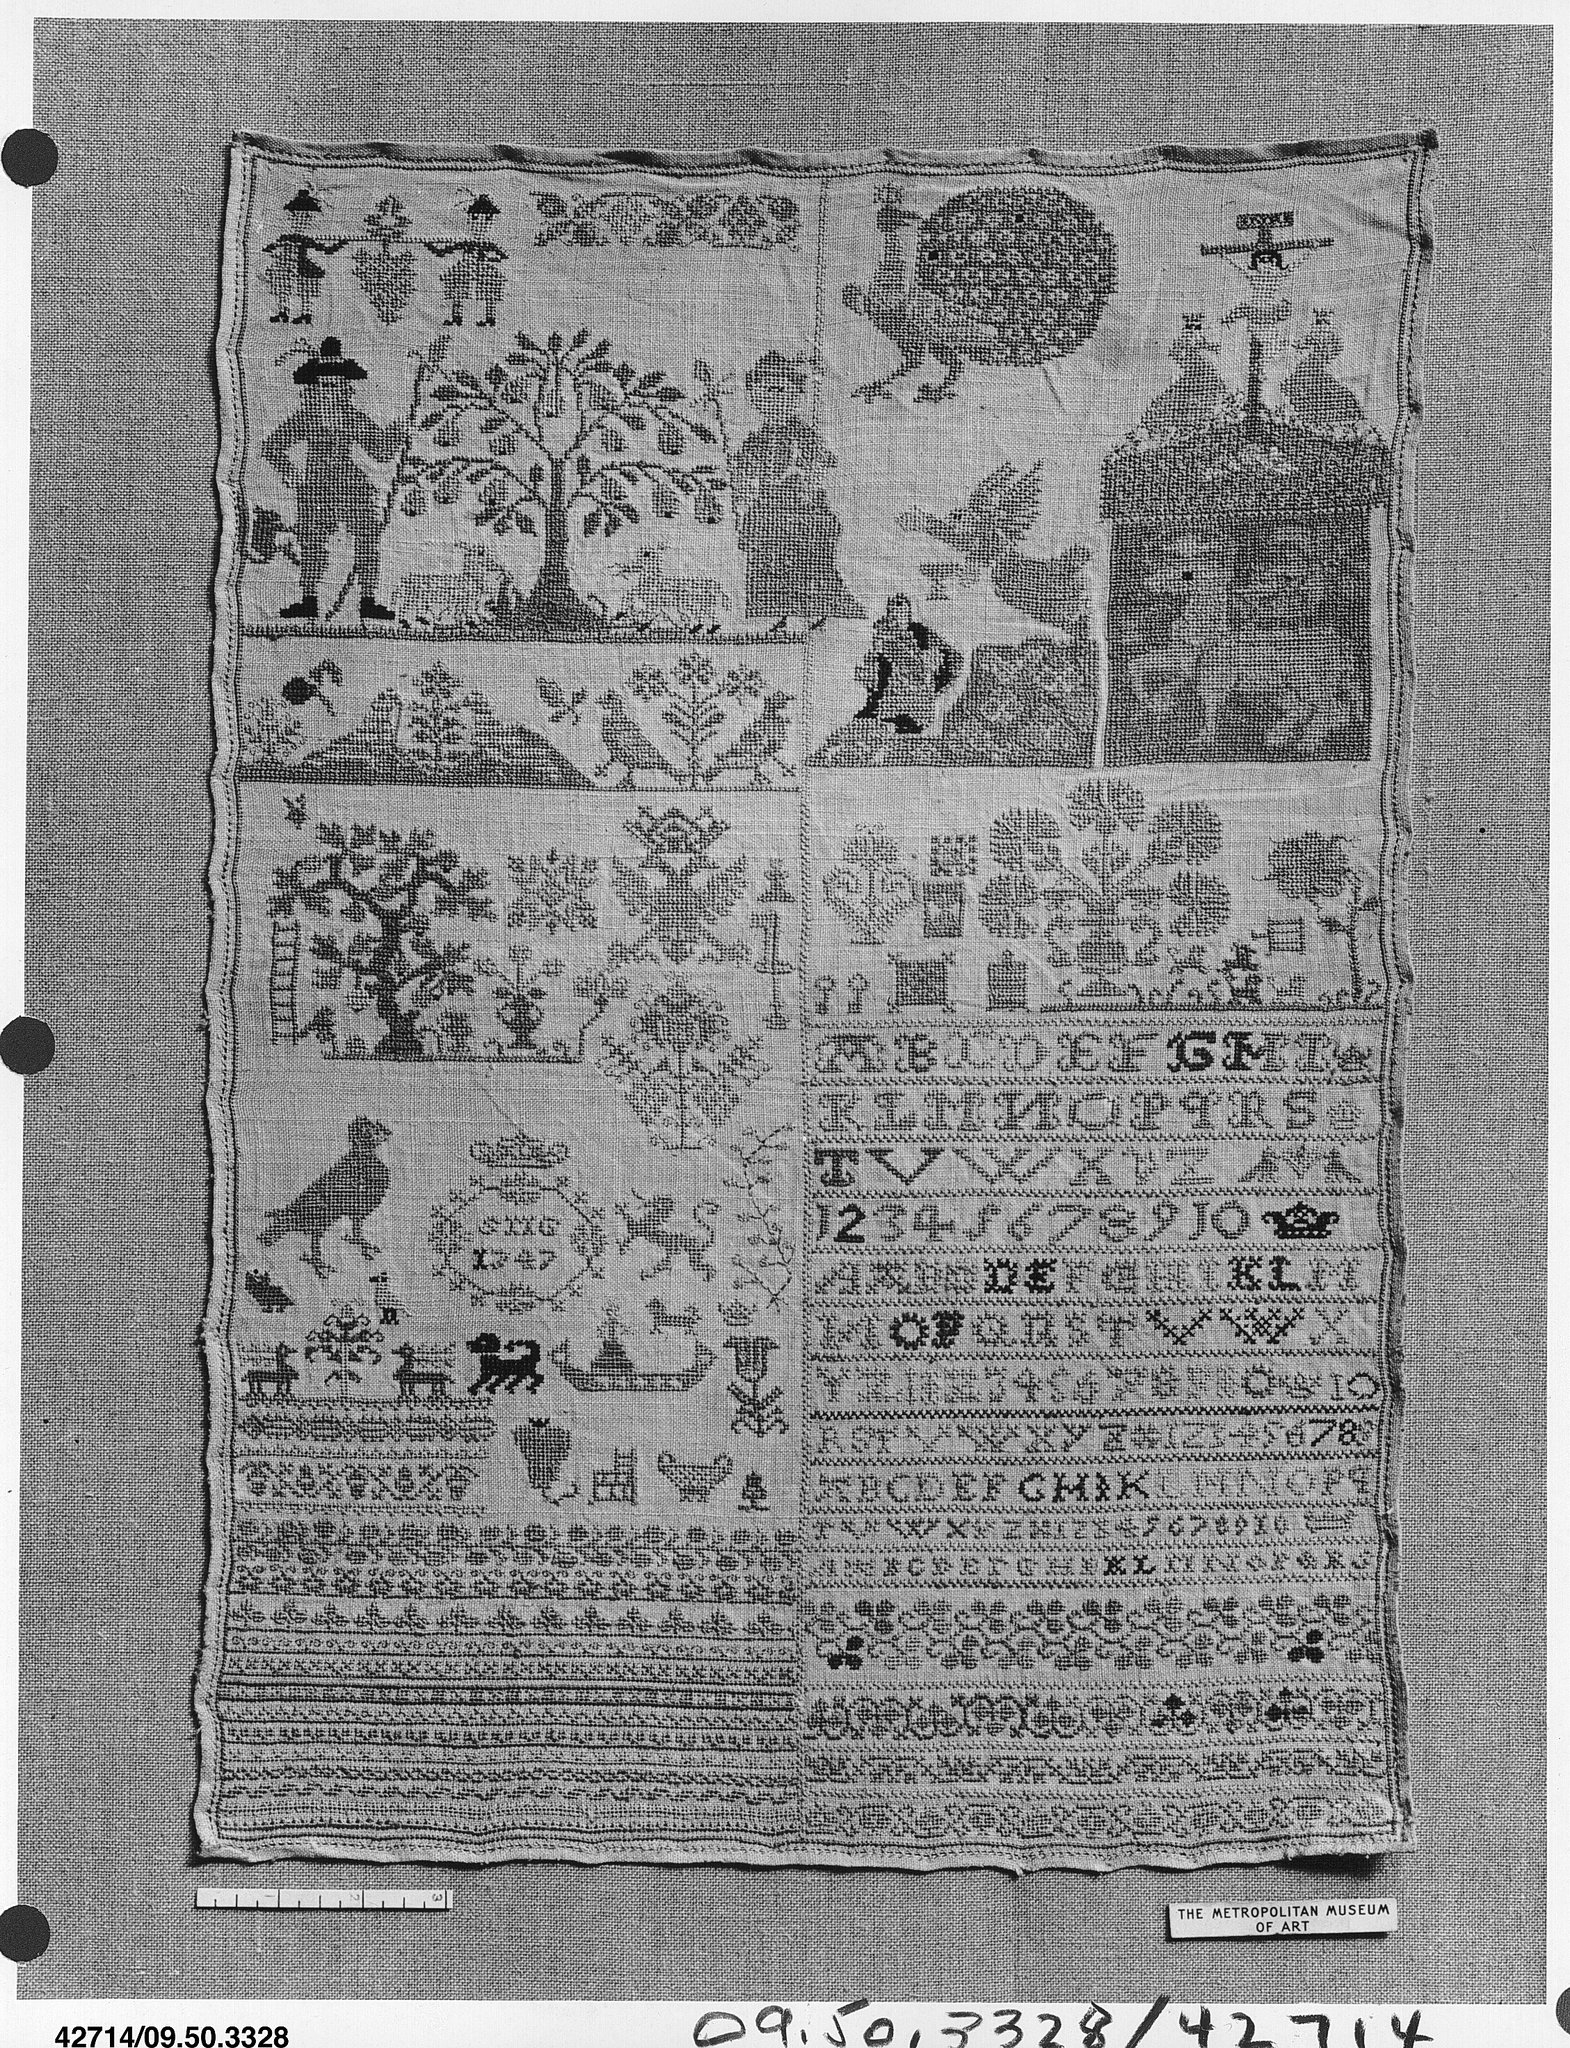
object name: sampler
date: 1787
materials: linen, silk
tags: peacocks